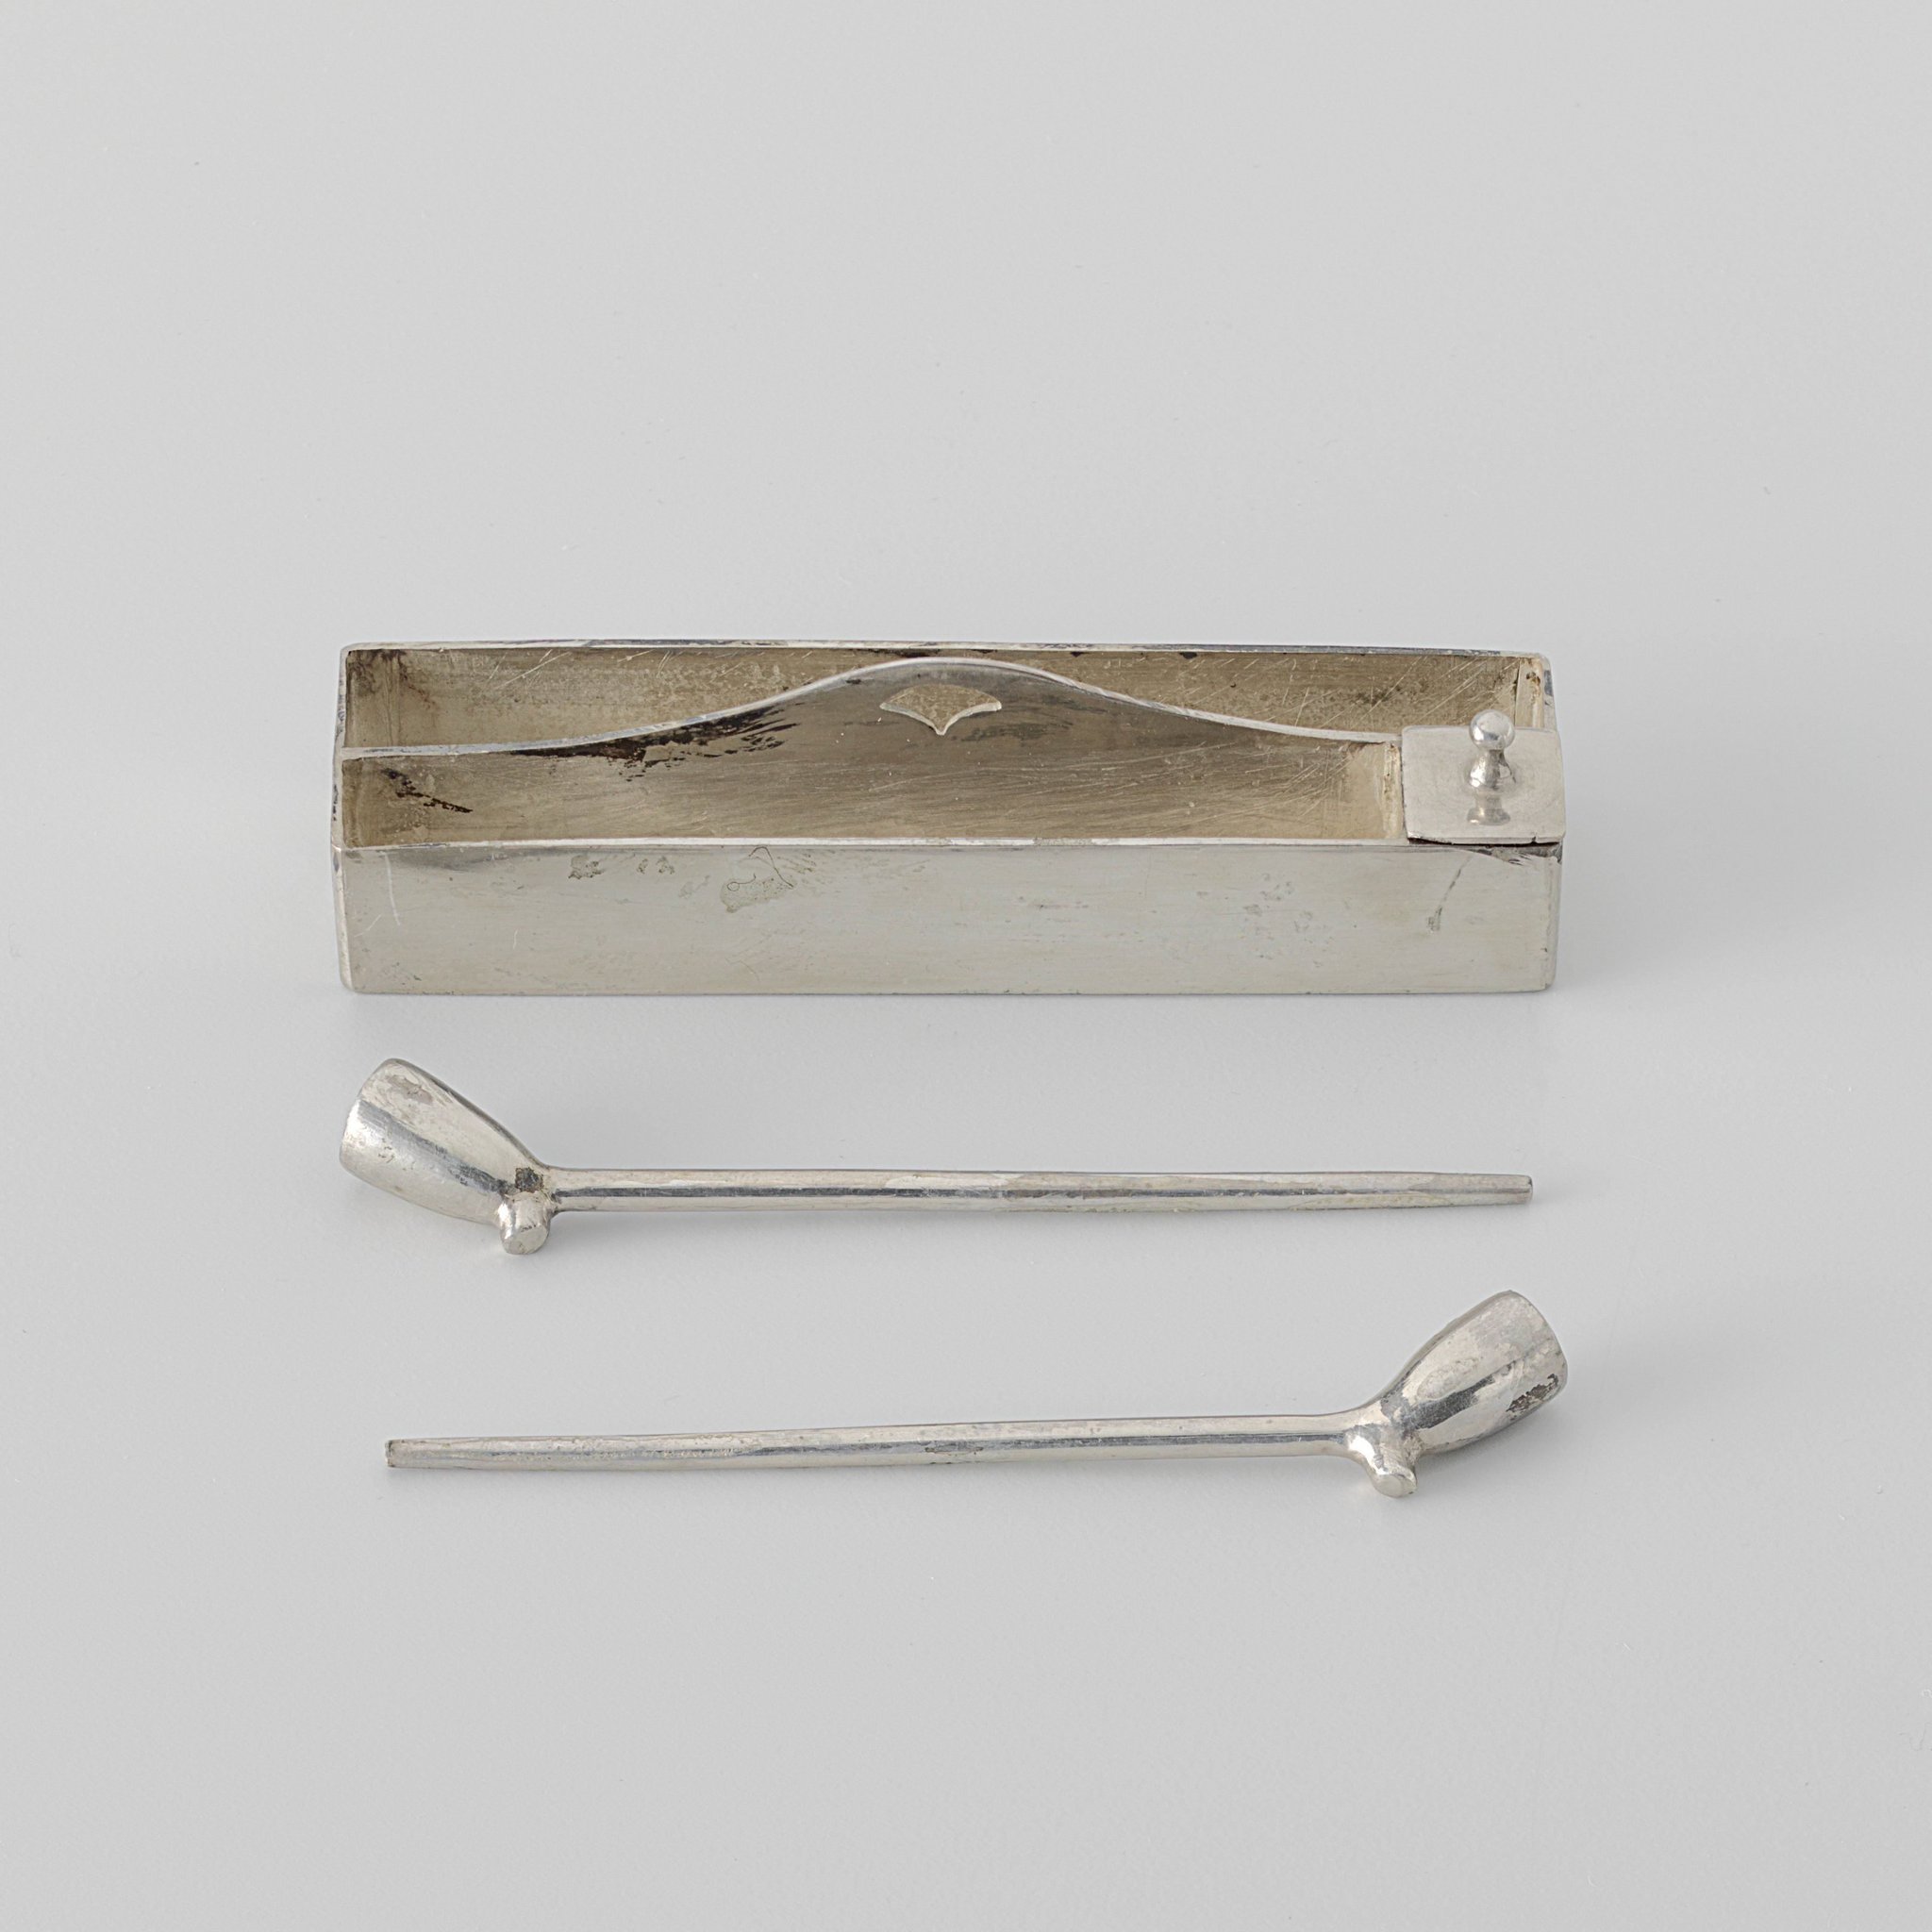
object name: miniature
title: Pijp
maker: b. dellemijn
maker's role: silversmith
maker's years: -1917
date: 1842-1898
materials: silver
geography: doesburg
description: Pijp met ronde kop en een lange gladde steel. De pijp wordt samen met twee andere pijpen (invnr. BK-NM-11177-141-b en BK-NM-11177-142-c) in een pijpenbak (invnr. BK-NM-11177-141-a) bewaard. De lange pijp met invnr. BK-NM-11177-141-c ontbreekt. De pijp is gemerkt met een zwaard.